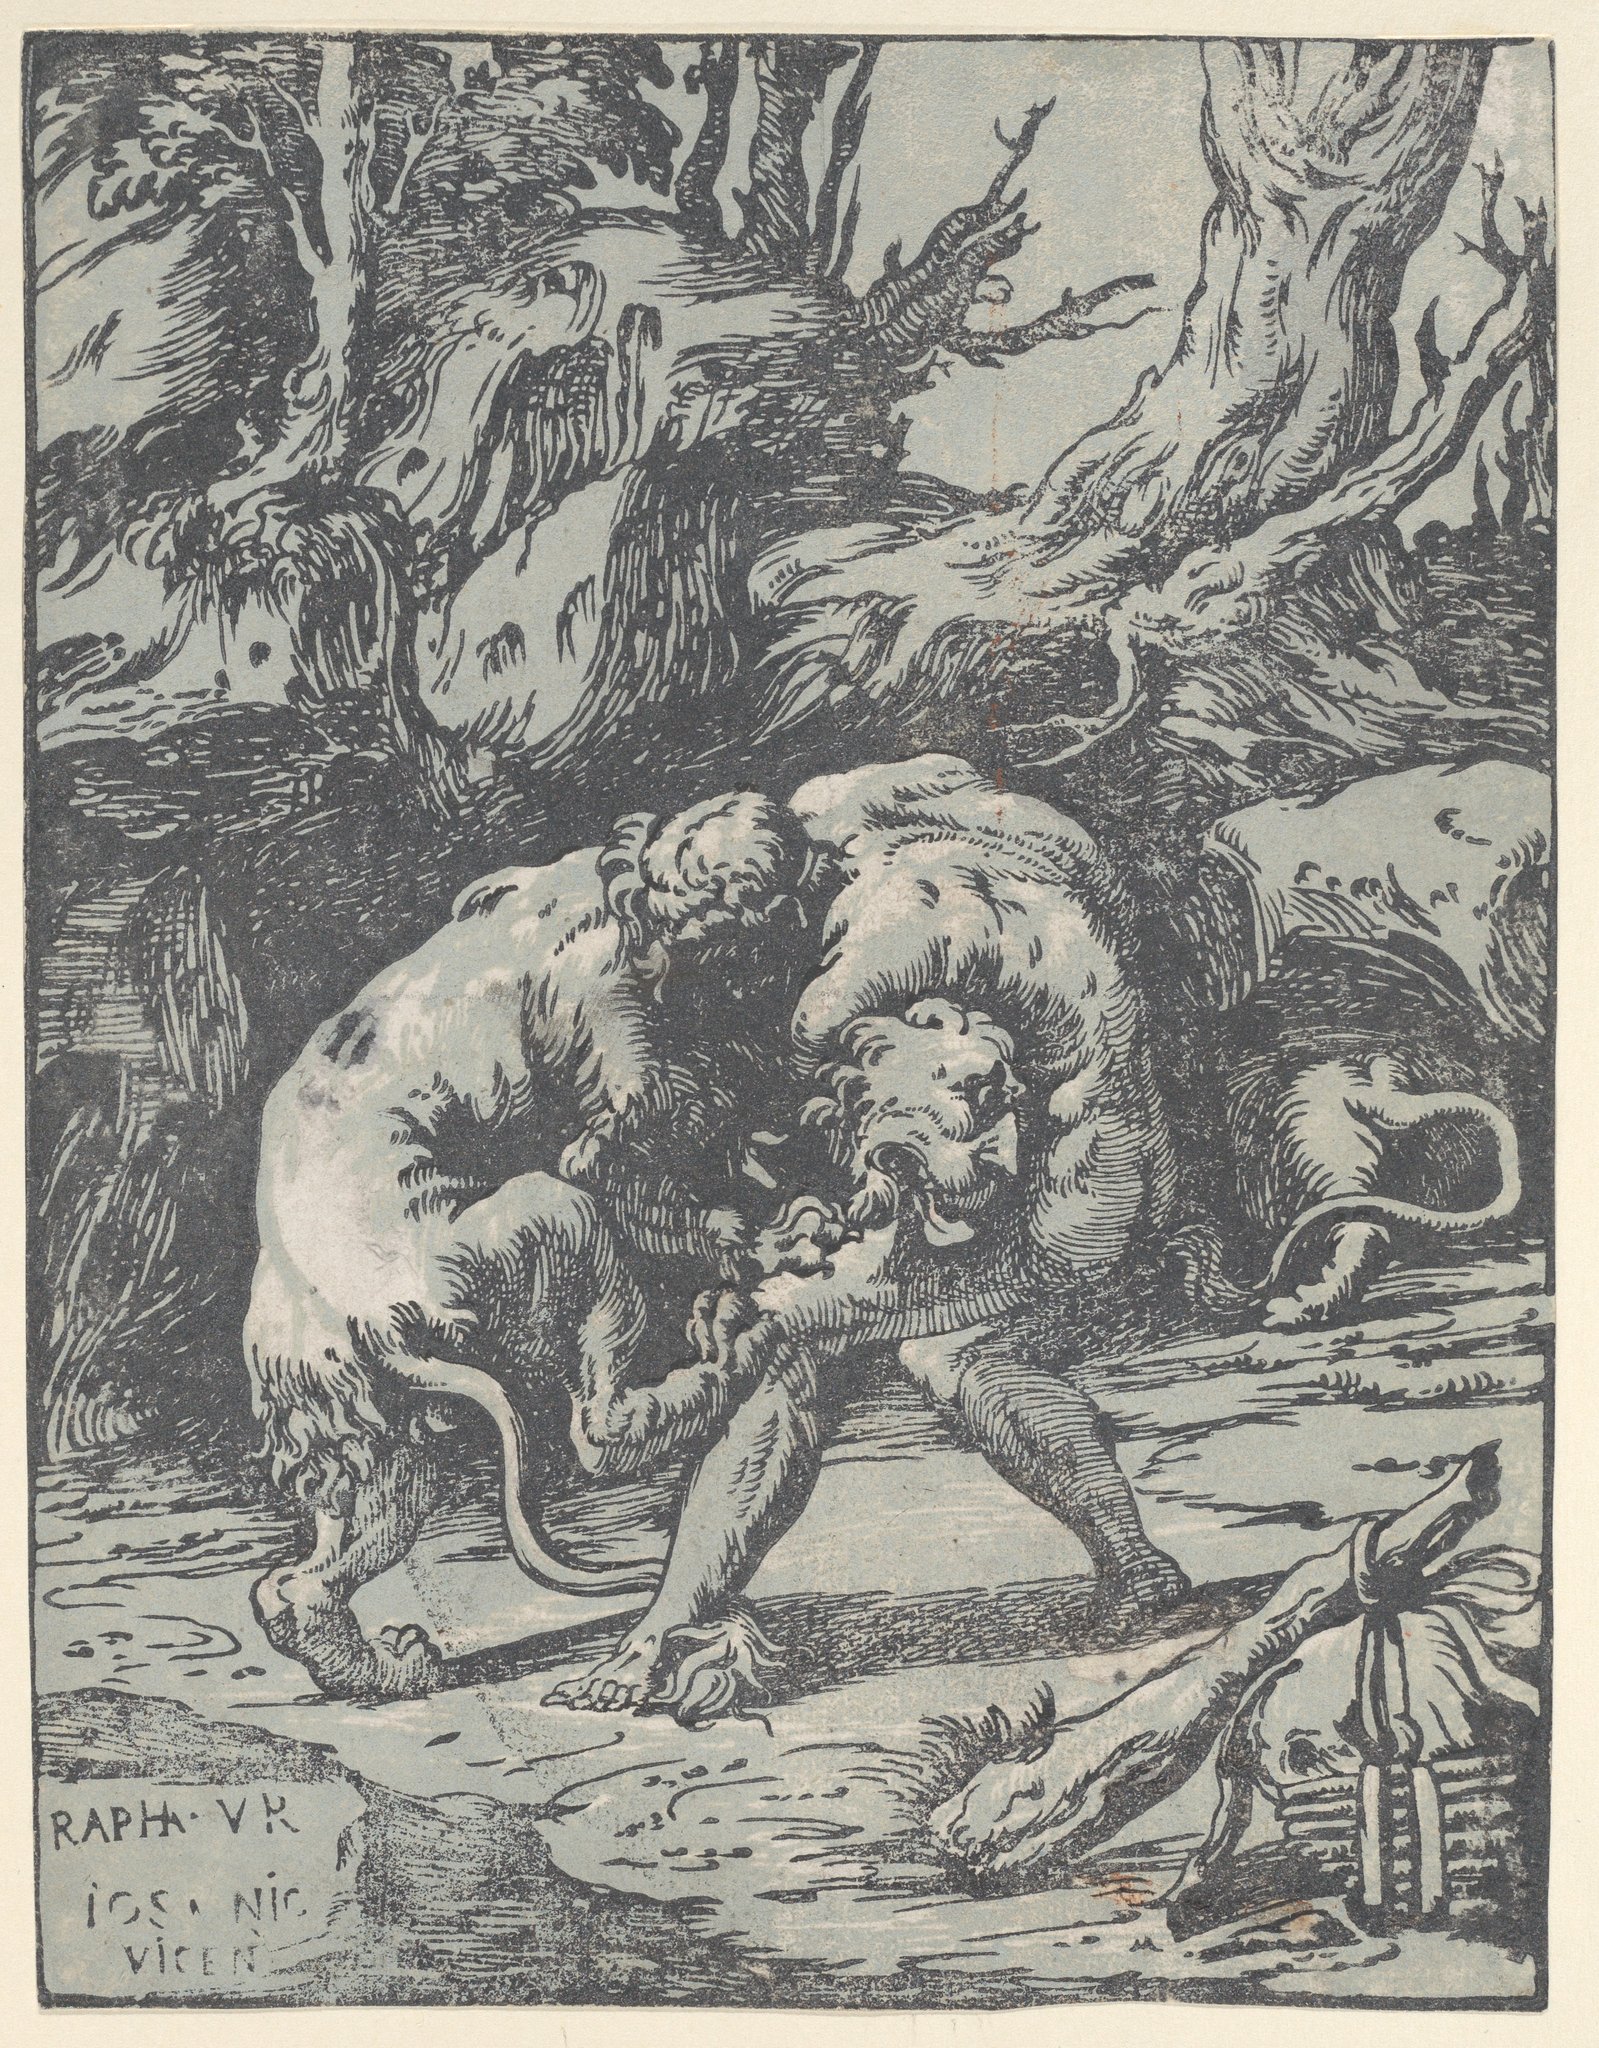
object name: print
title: Hercules and the Nemean Lion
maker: niccolò vicentino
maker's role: artist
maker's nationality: italian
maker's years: 1510-1550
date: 1540-1550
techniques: woodcut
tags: men,hercules,lions